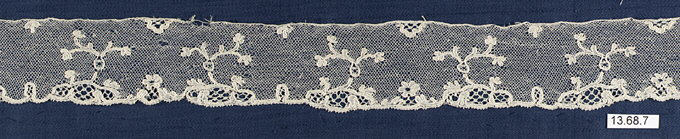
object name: fragment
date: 1801-1833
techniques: lace